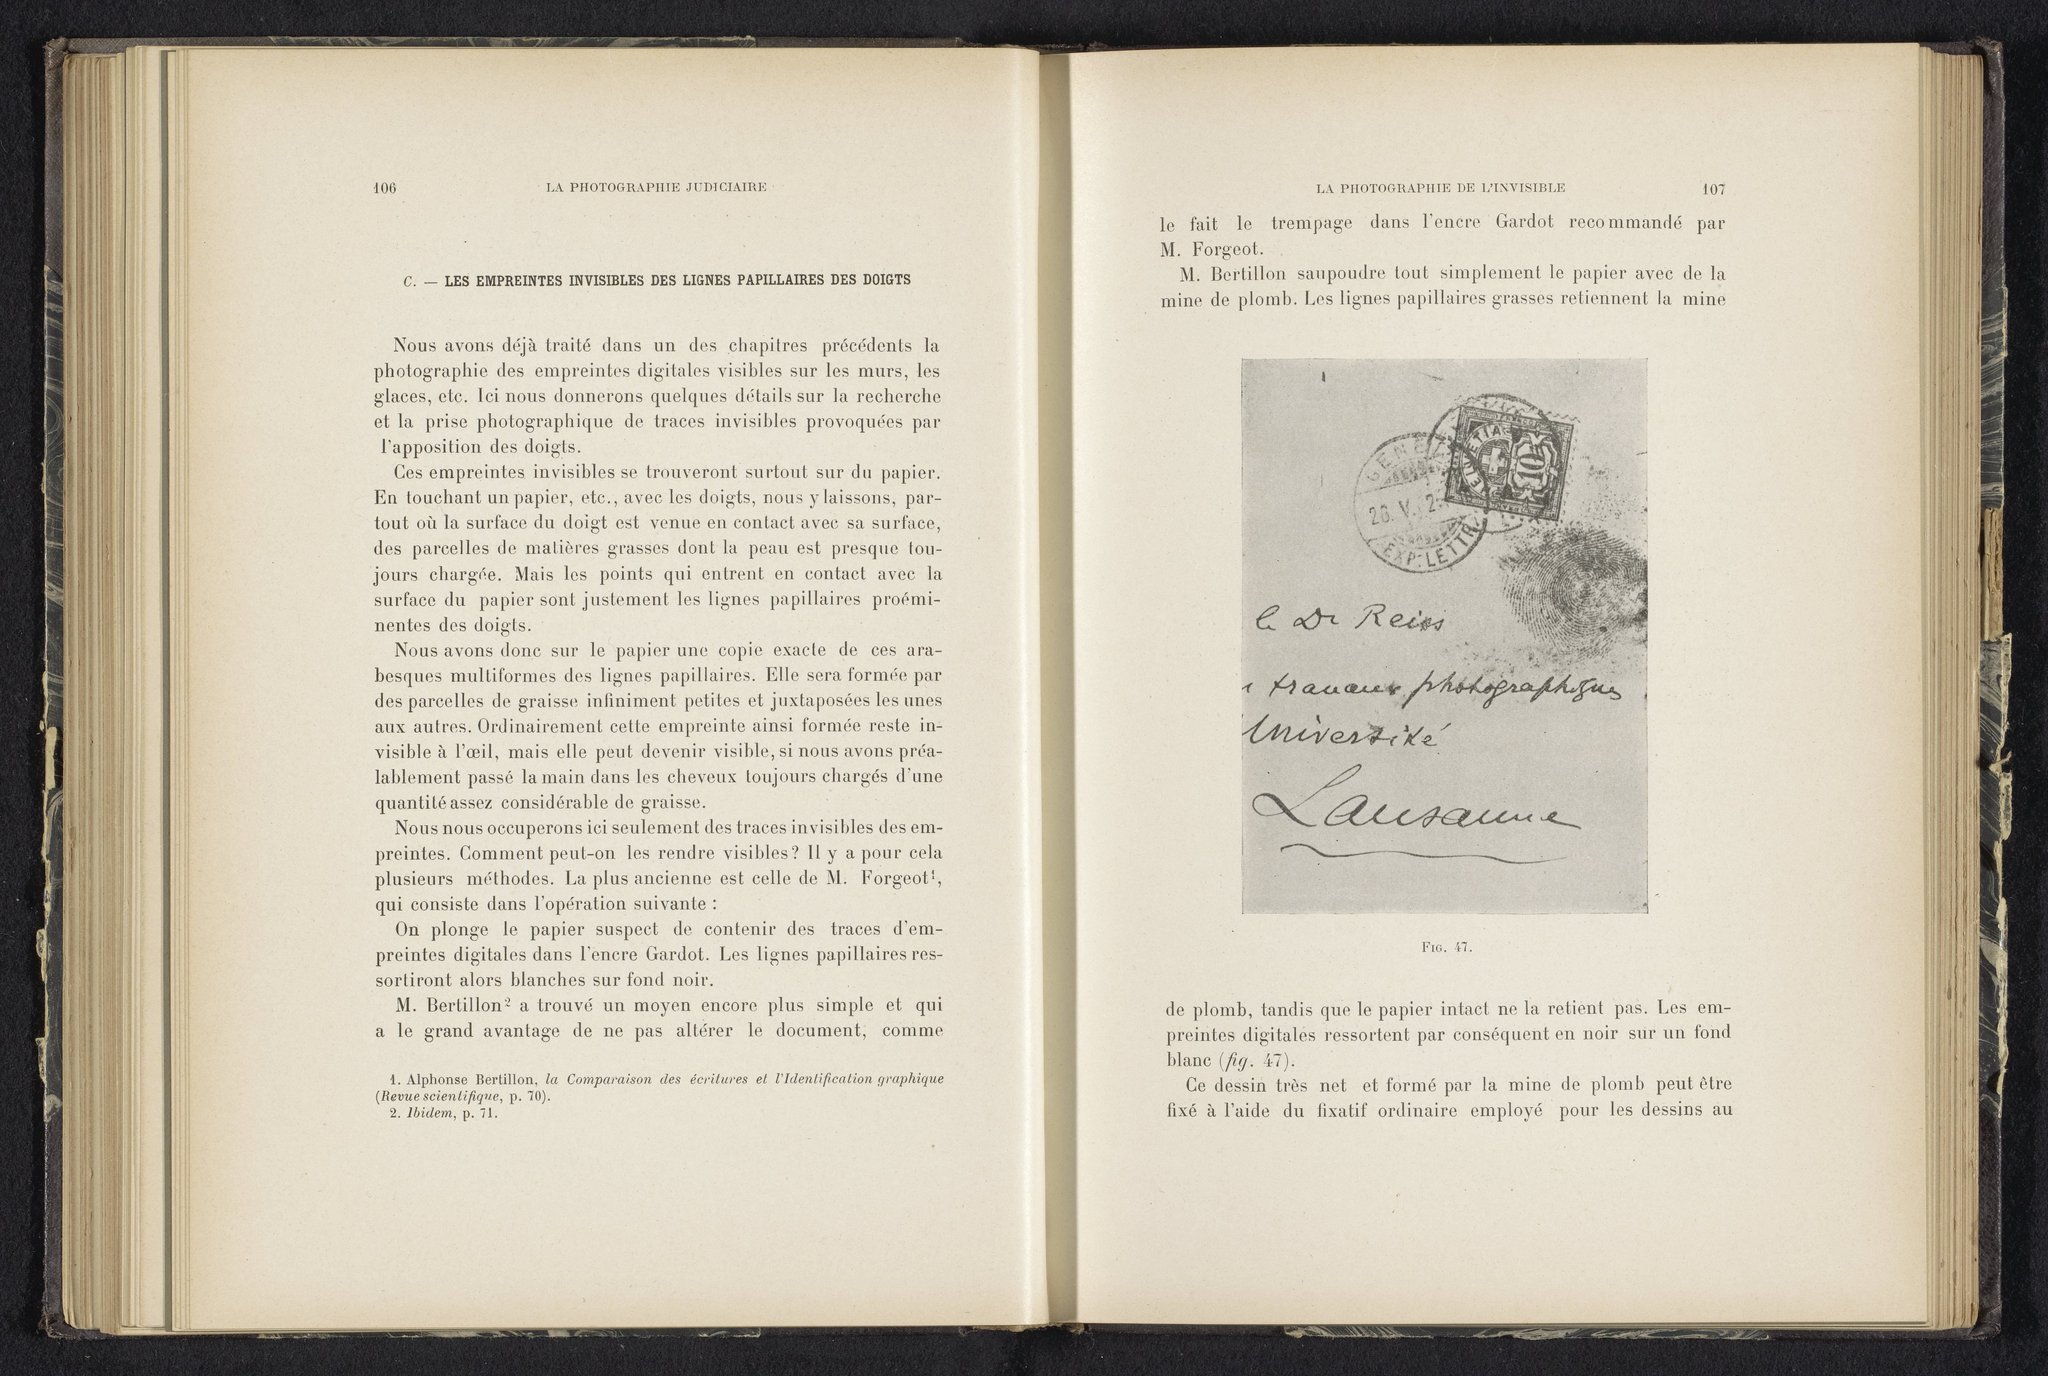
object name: page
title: Deel van een envelop met een vingerafdruk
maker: Anonymous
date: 1893-1903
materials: paper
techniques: autotype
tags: finger-prints, letter, envelope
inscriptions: number: ‘Fig. 47.’